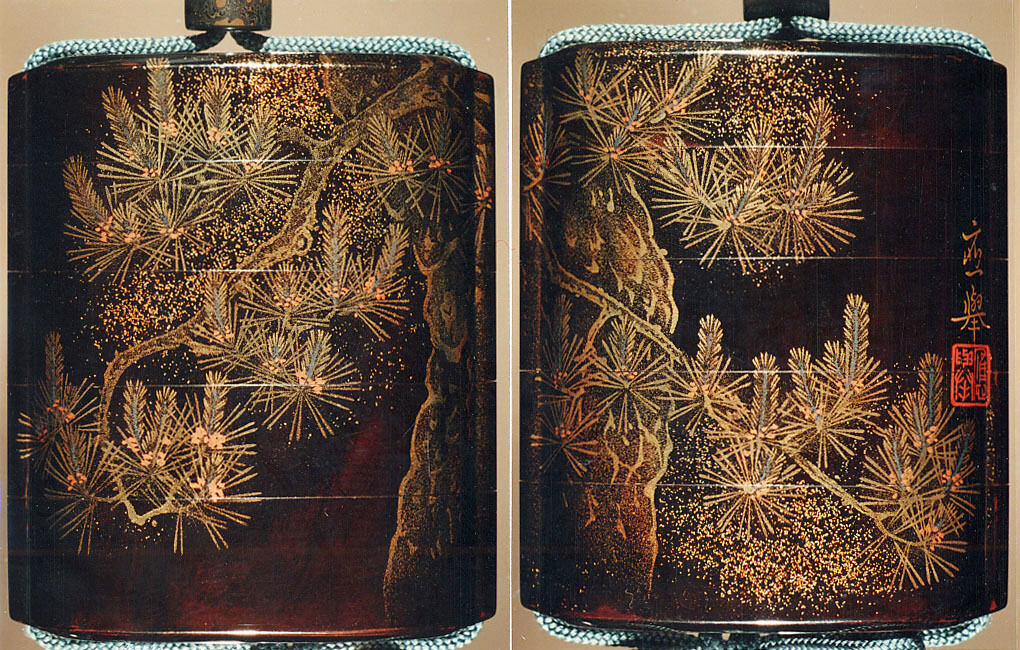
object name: inrō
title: Case (Inrō) with Design of Pines Tree and Branches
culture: japanese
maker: maruyama ōkyo 円山応挙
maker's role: artist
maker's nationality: japanese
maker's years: 1733-1795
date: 1701-1900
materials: gold, lacquer, silver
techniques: fundame, roiro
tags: trees